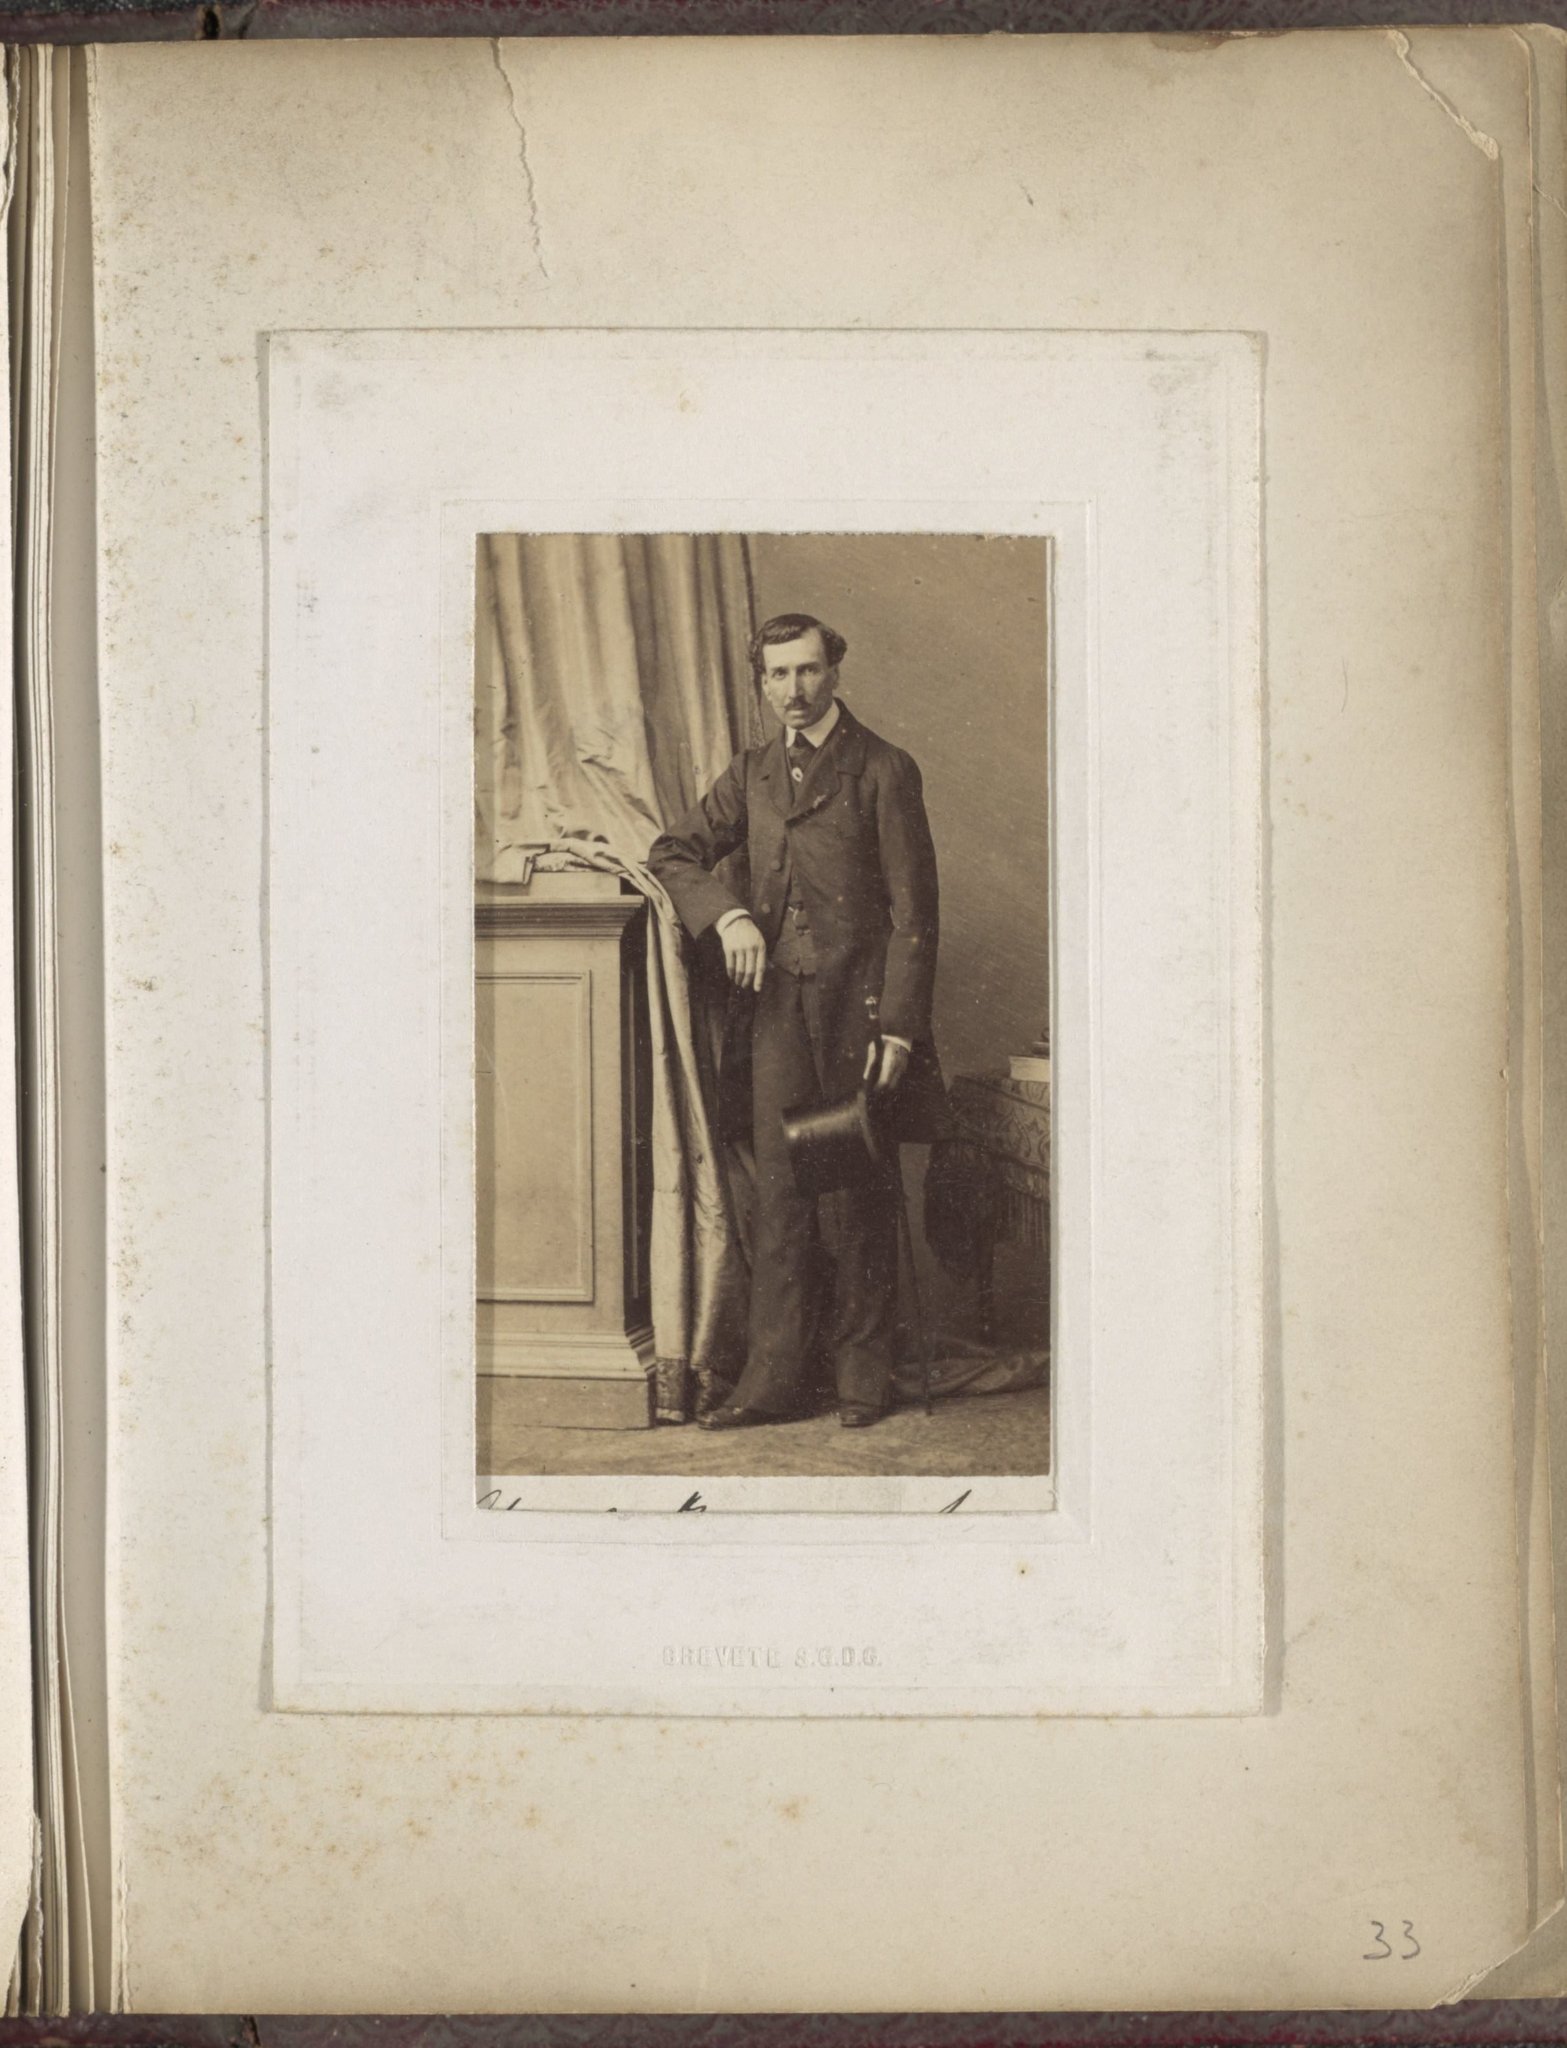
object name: photograph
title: Cte. de Beaumont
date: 1860-1865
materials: cardboard, paper, photographic support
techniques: albumen print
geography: paris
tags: earl, studio requisites ~ photographer, trousers, breeches, walking-stick, staff, moustache, historical persons, shoes, sandals, hairdress, coat, cape, head-gear: top hat, paris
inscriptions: address: ‘8, Boulevart des Italiens Paris’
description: Onderdeel van Fotoalbum met 28 cartes-de-visite van Franse personen.